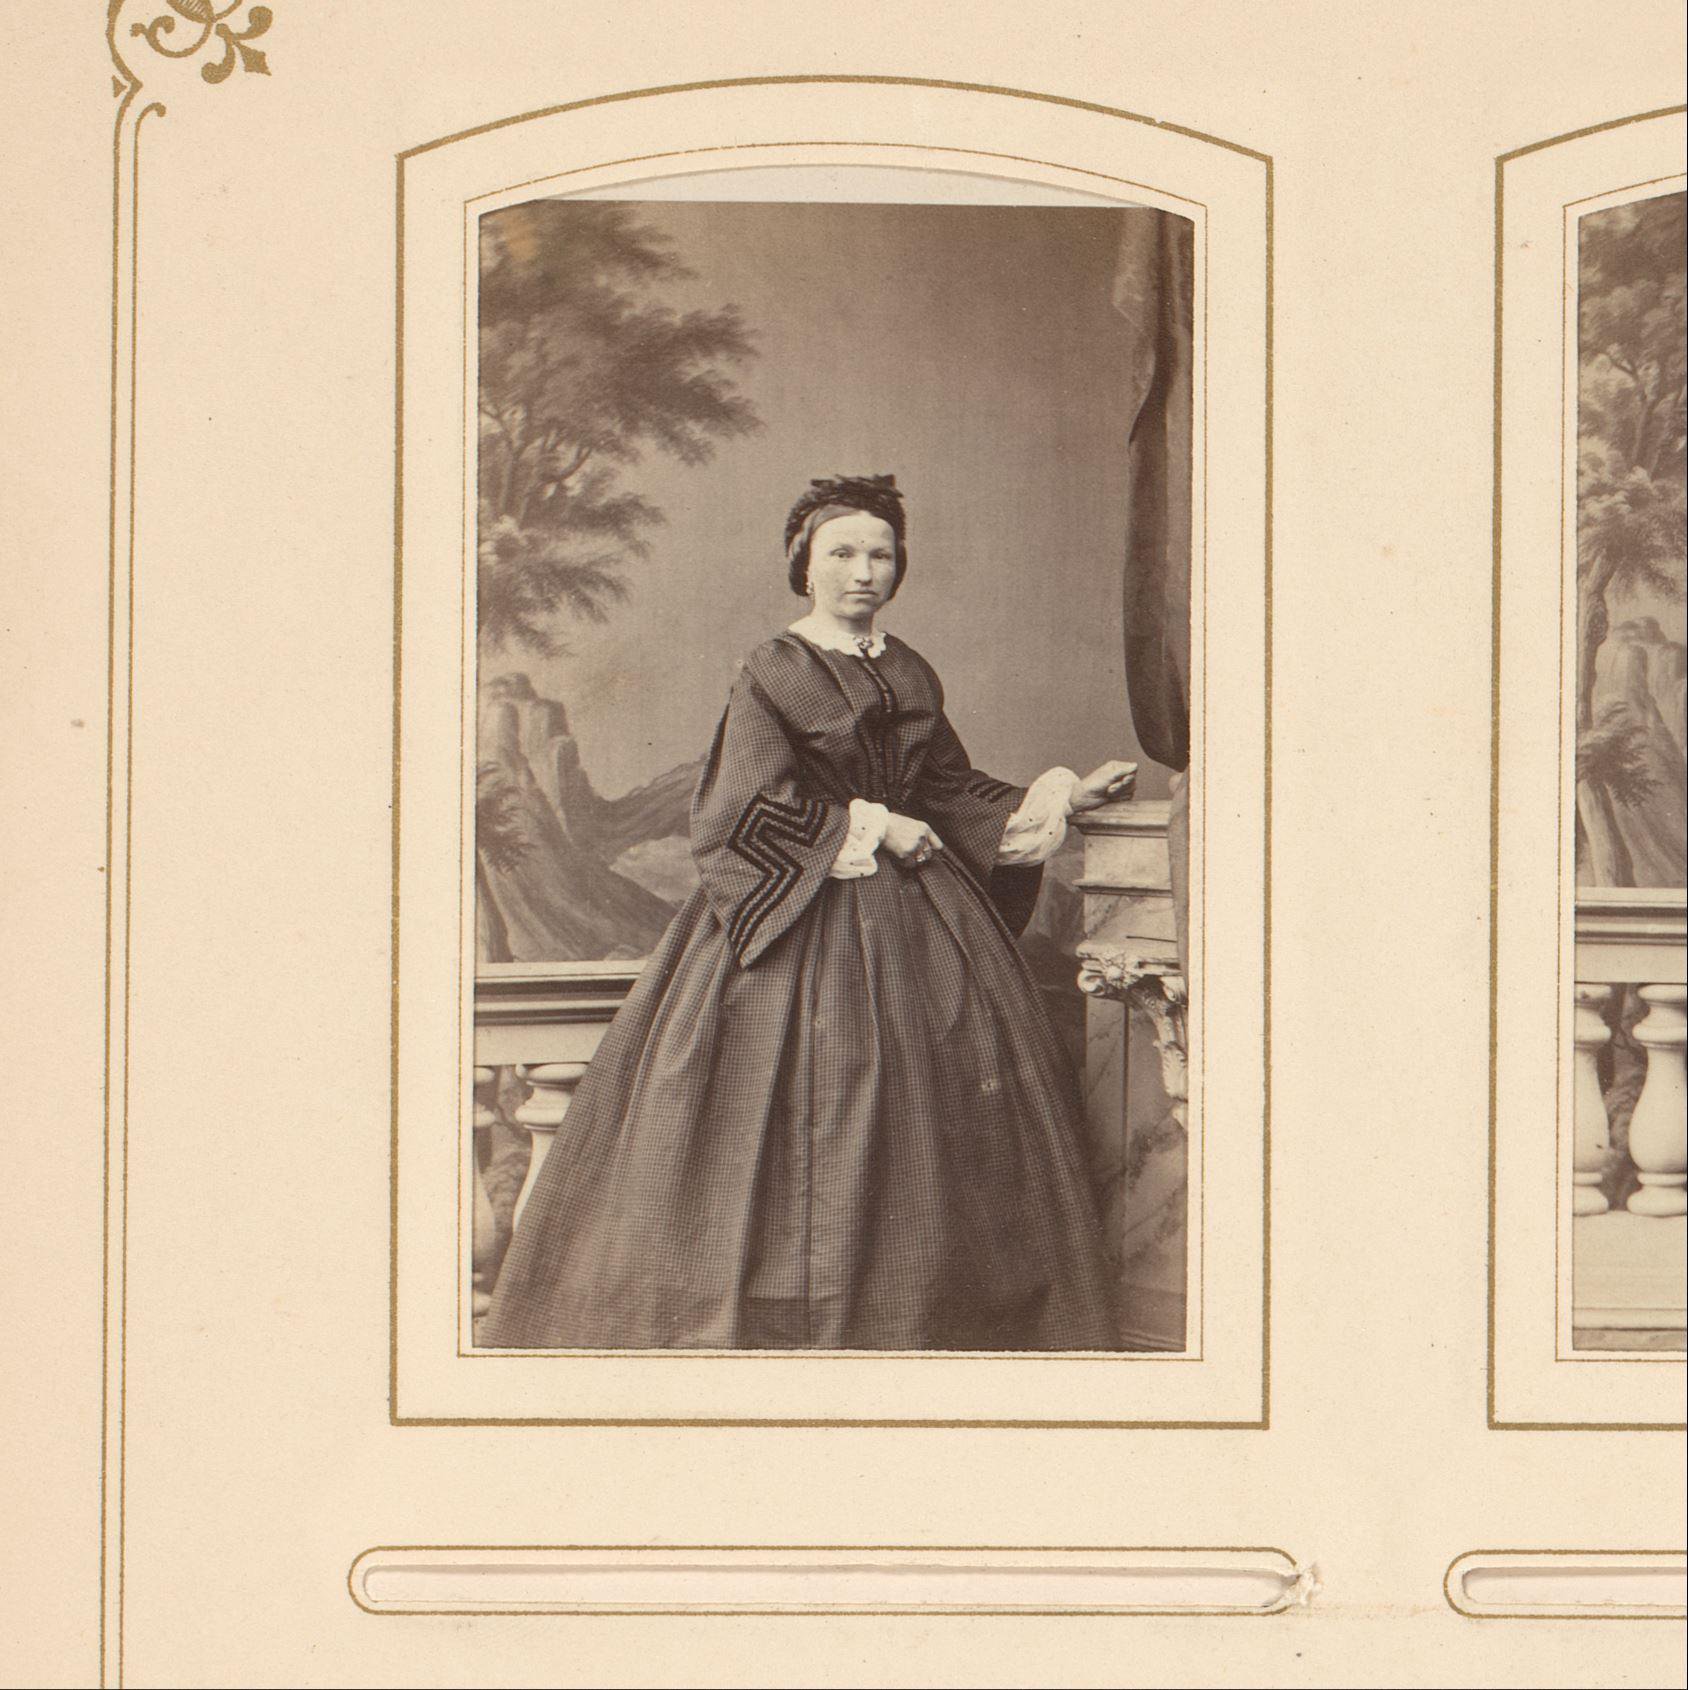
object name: carte de visite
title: Portret van een vrouw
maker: Anonymous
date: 1850-1900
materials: cardboard, photographic support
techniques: albumen print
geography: germany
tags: historical persons - bb - woman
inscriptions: annotation: ‘Tante hir[.]a Sch[ät]ze’